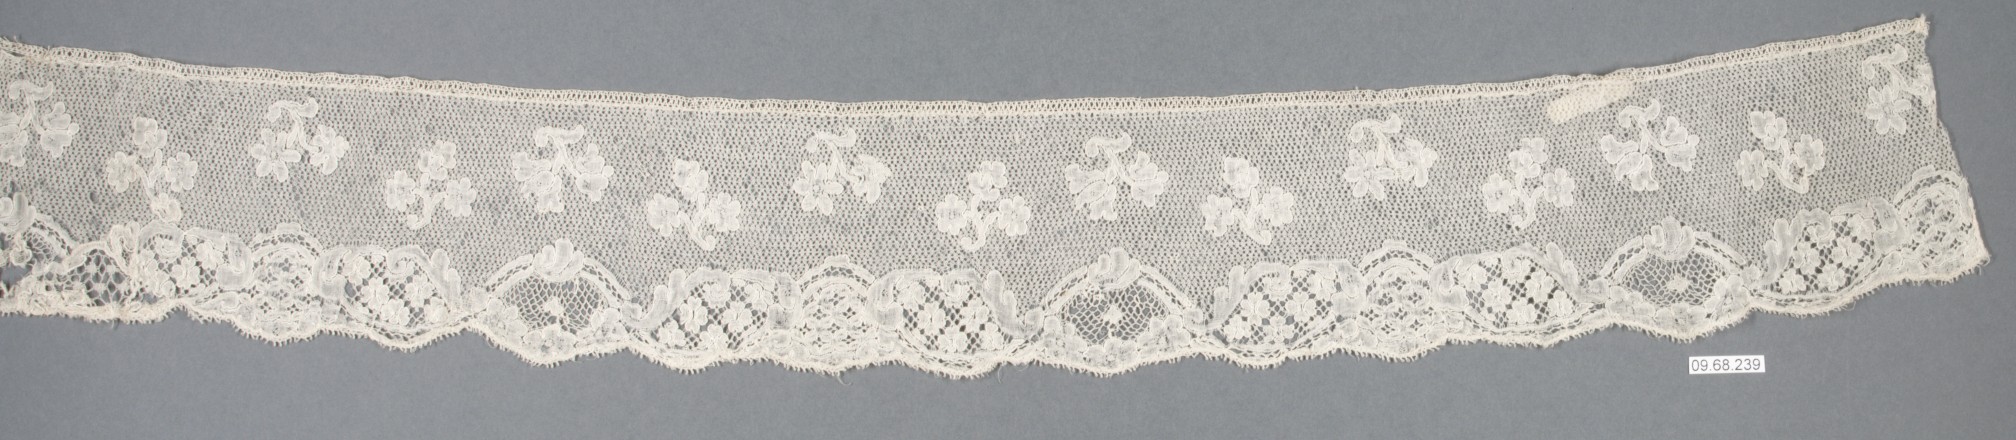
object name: cuff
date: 1701-1800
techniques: lace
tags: flowers